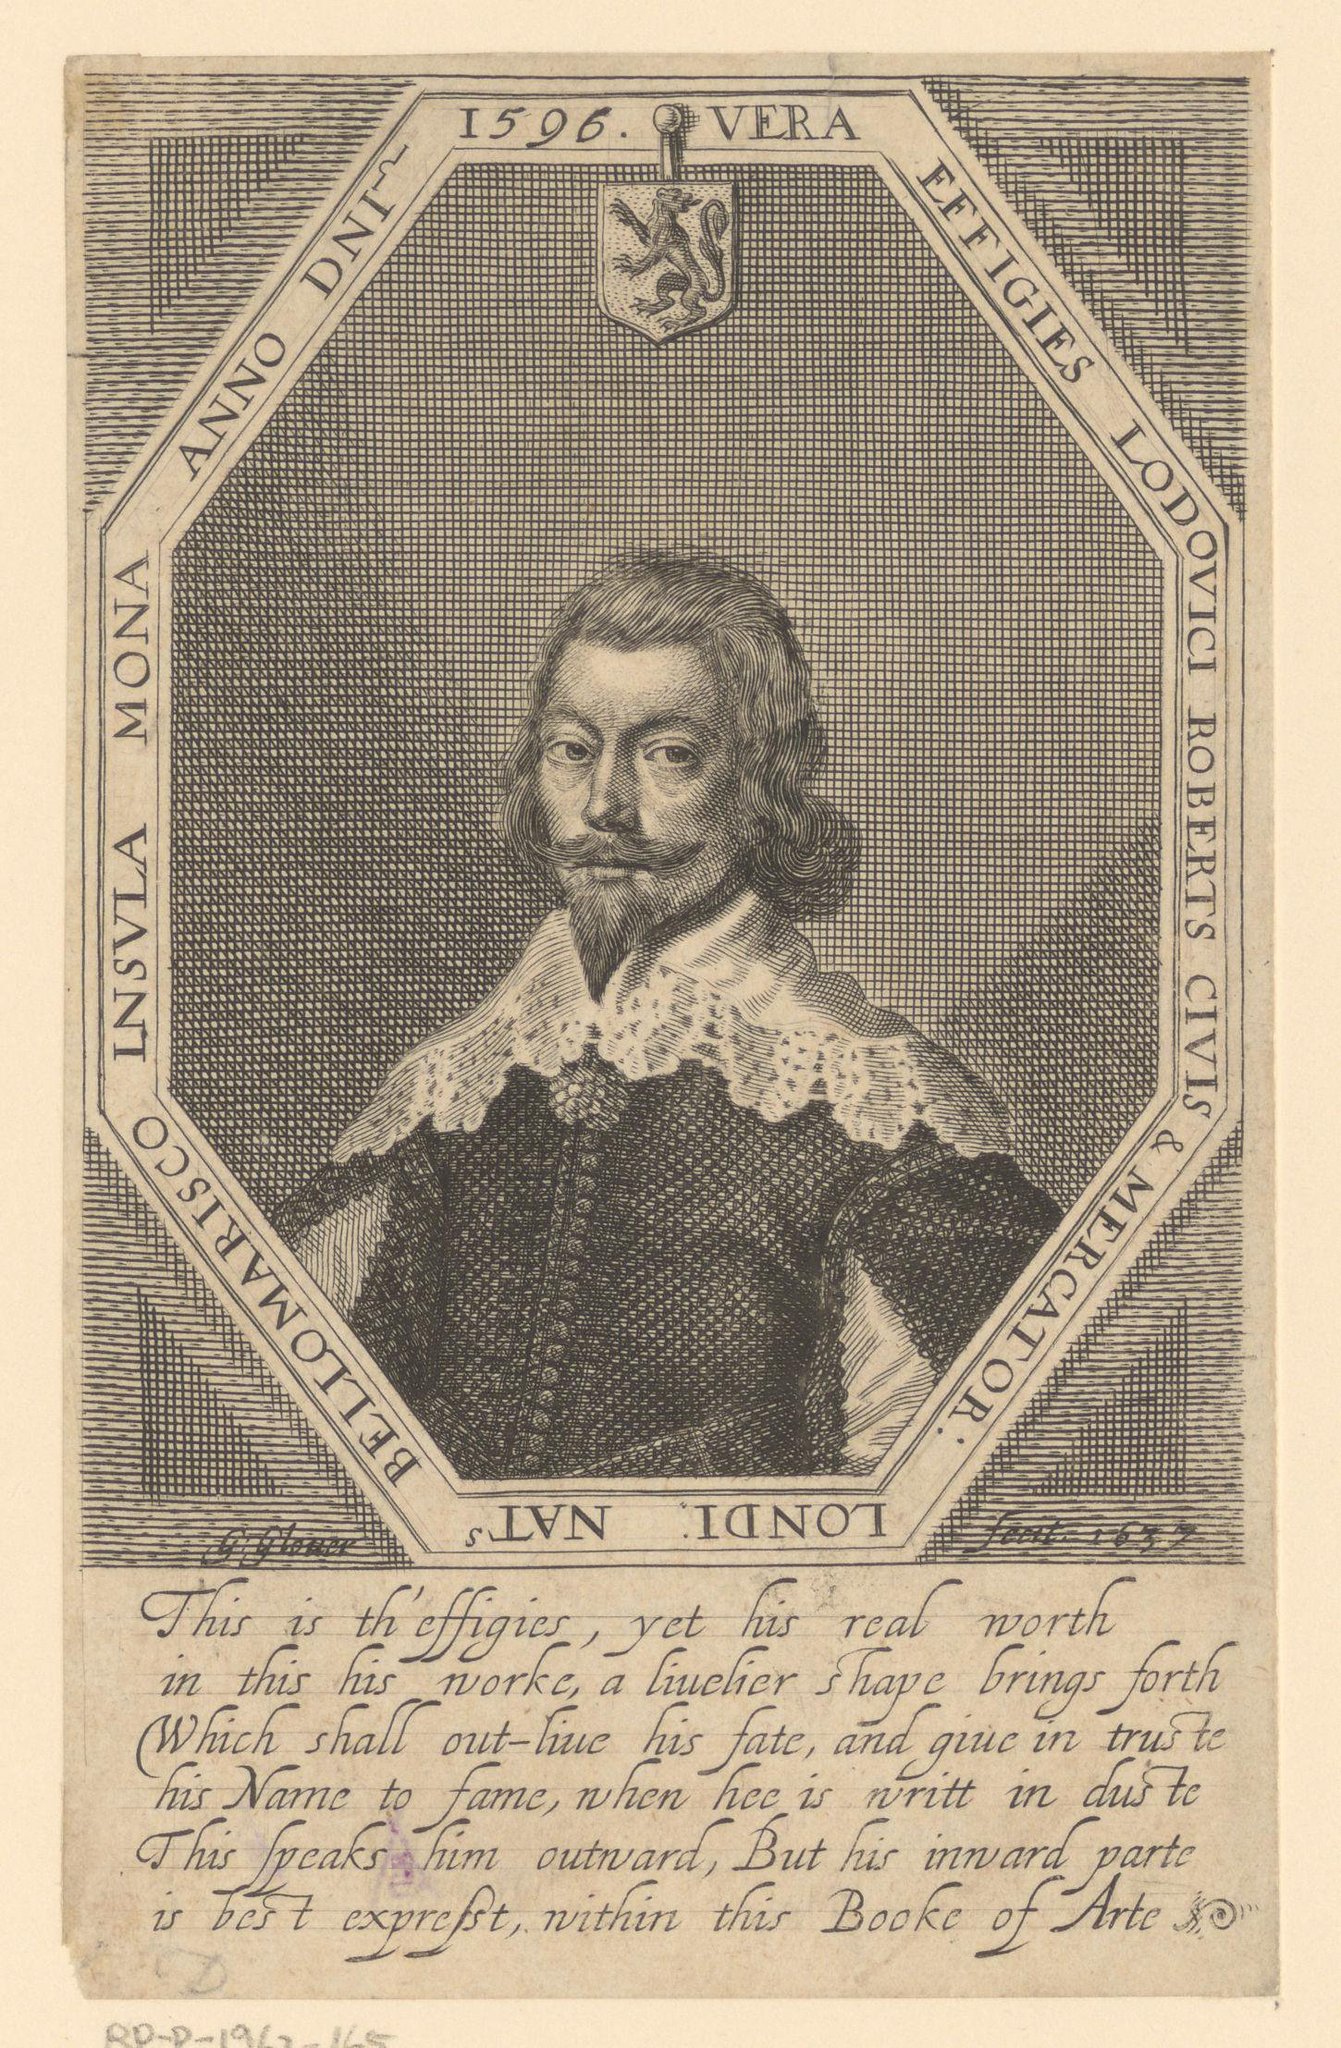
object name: print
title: Portret van Lewis Roberts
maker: george glover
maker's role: print maker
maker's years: 1618-1650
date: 1637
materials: paper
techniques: engraving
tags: historical persons, portrait of a writer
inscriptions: collector's mark: Lugt 2228, collector's mark, collector's mark, collector's mark: Lugt 2228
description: Prent gebruikt in: Roberts, Lewis. Merchants mappe of commerce. Londen: R.O. for Ralph Mabb, 1638.